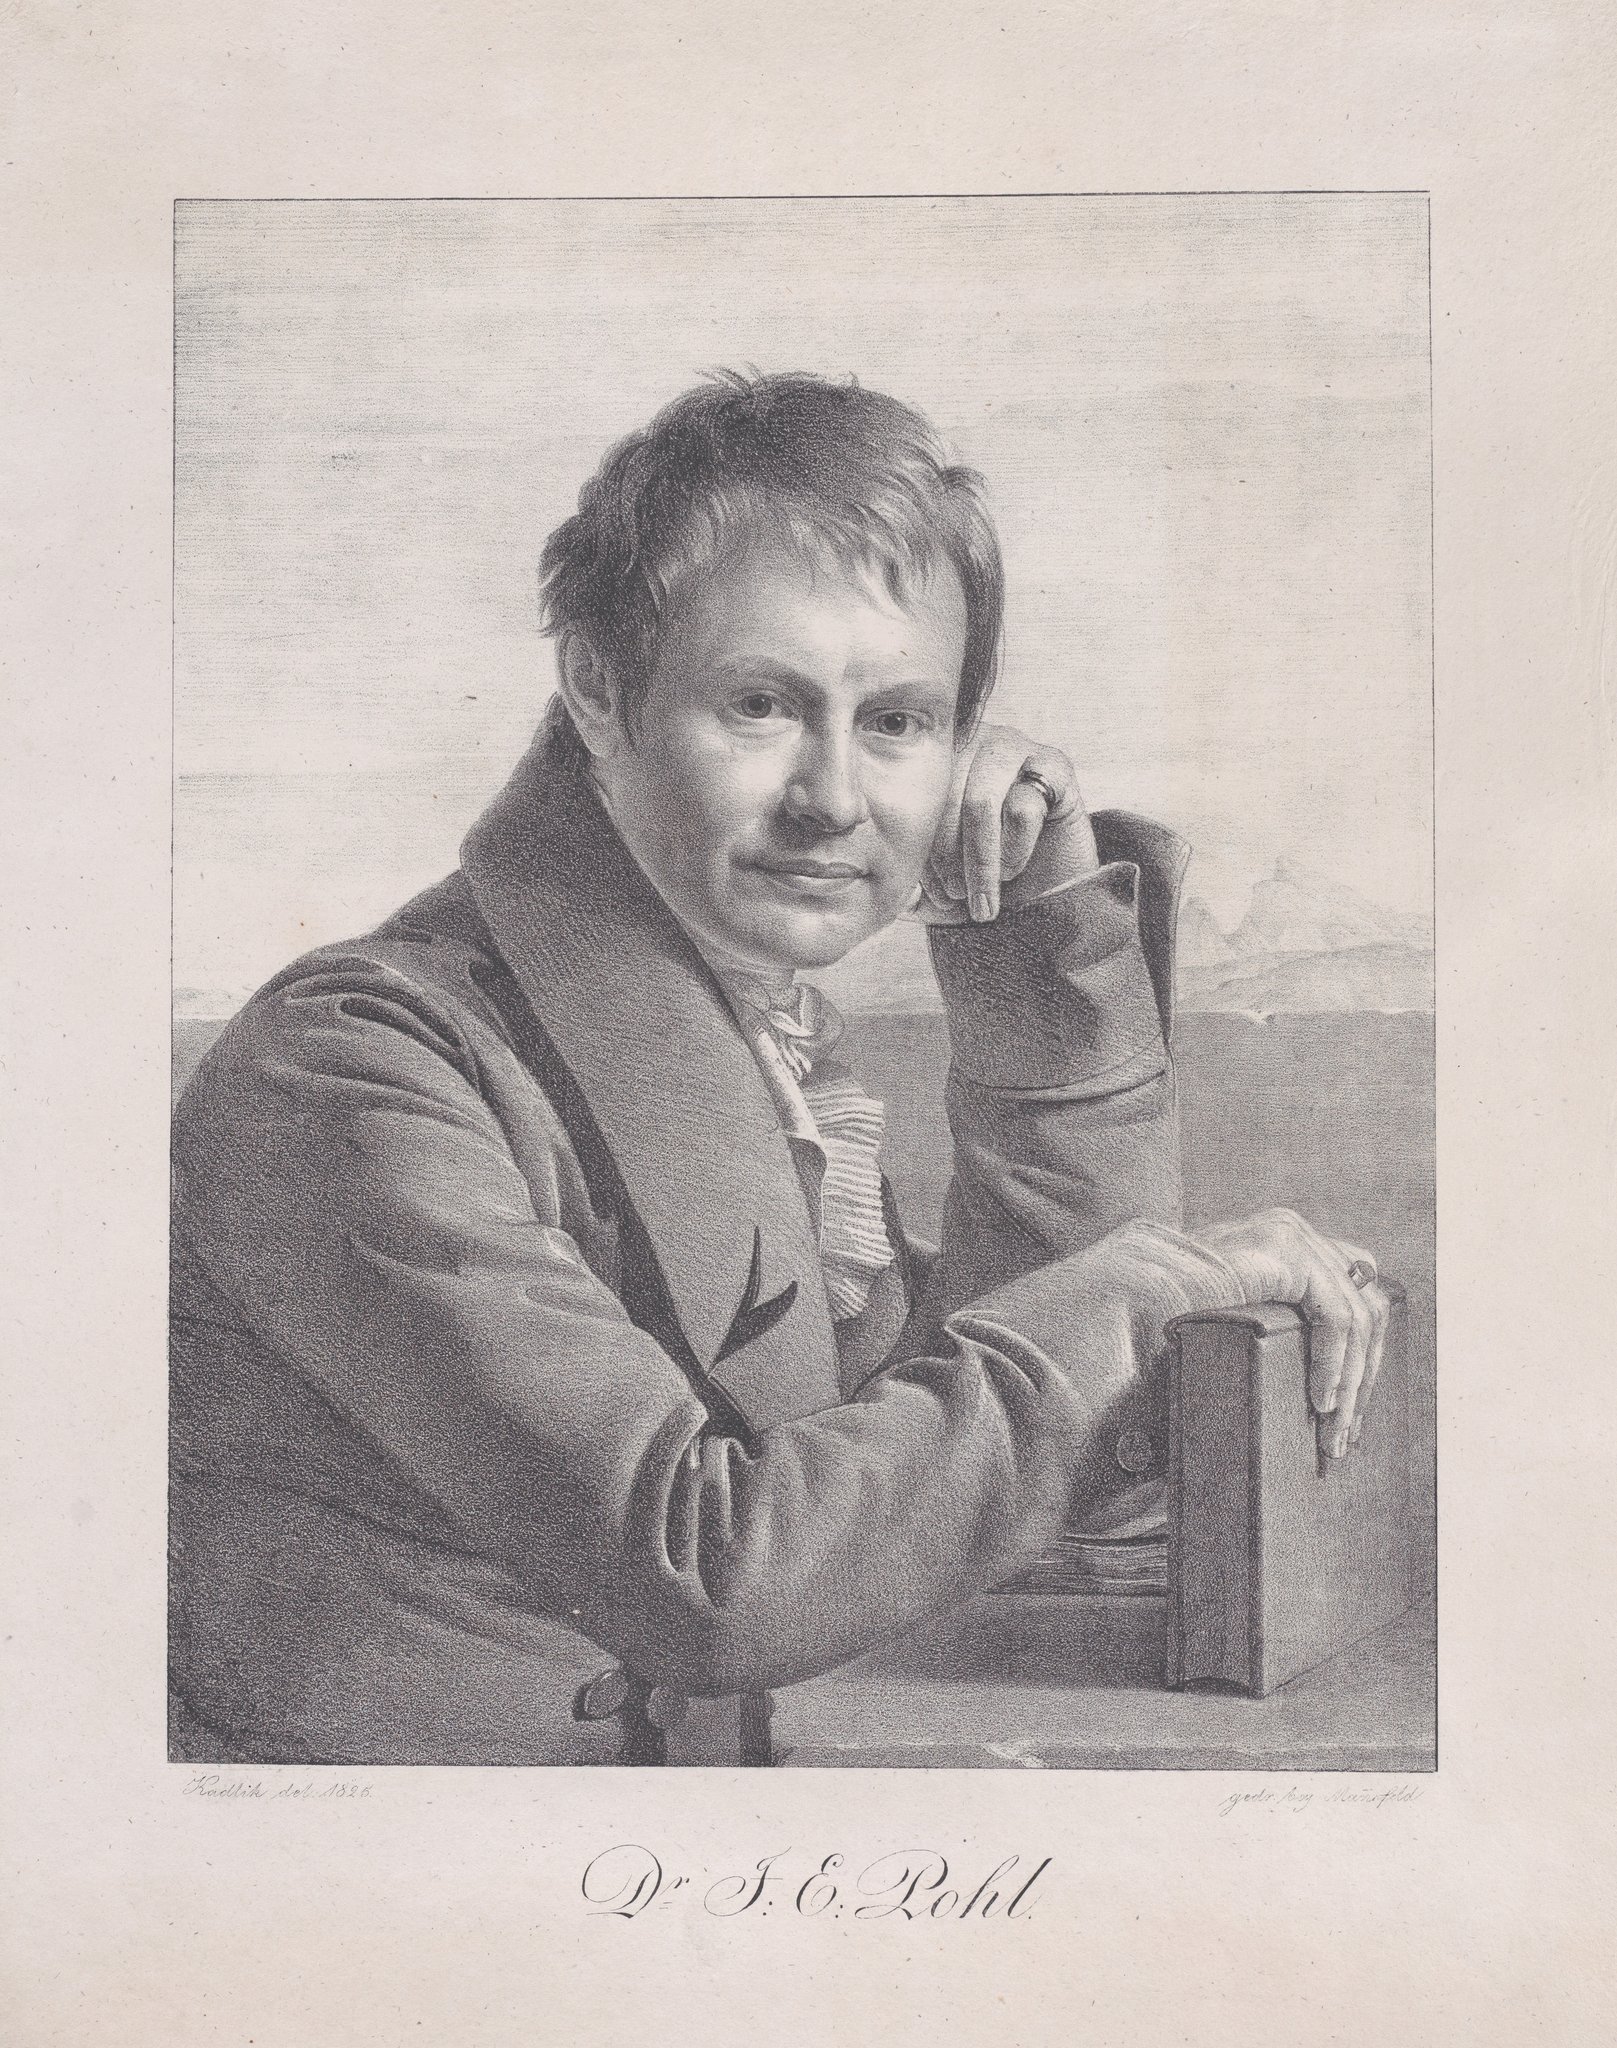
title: Portrait of Dr. J.E. Pohl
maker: franz kadlik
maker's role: artist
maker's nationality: czech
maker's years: 1786-1840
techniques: lithograph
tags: men,portraits